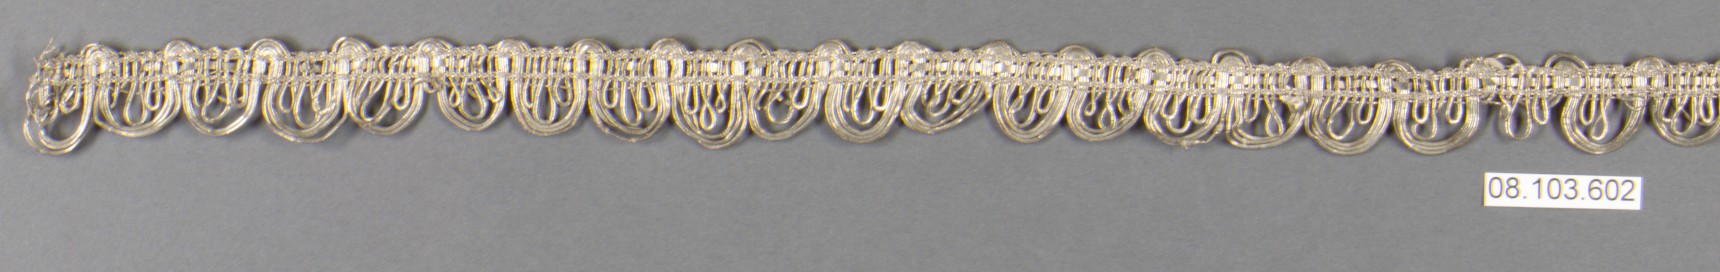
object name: galloon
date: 1701-1800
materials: metal thread